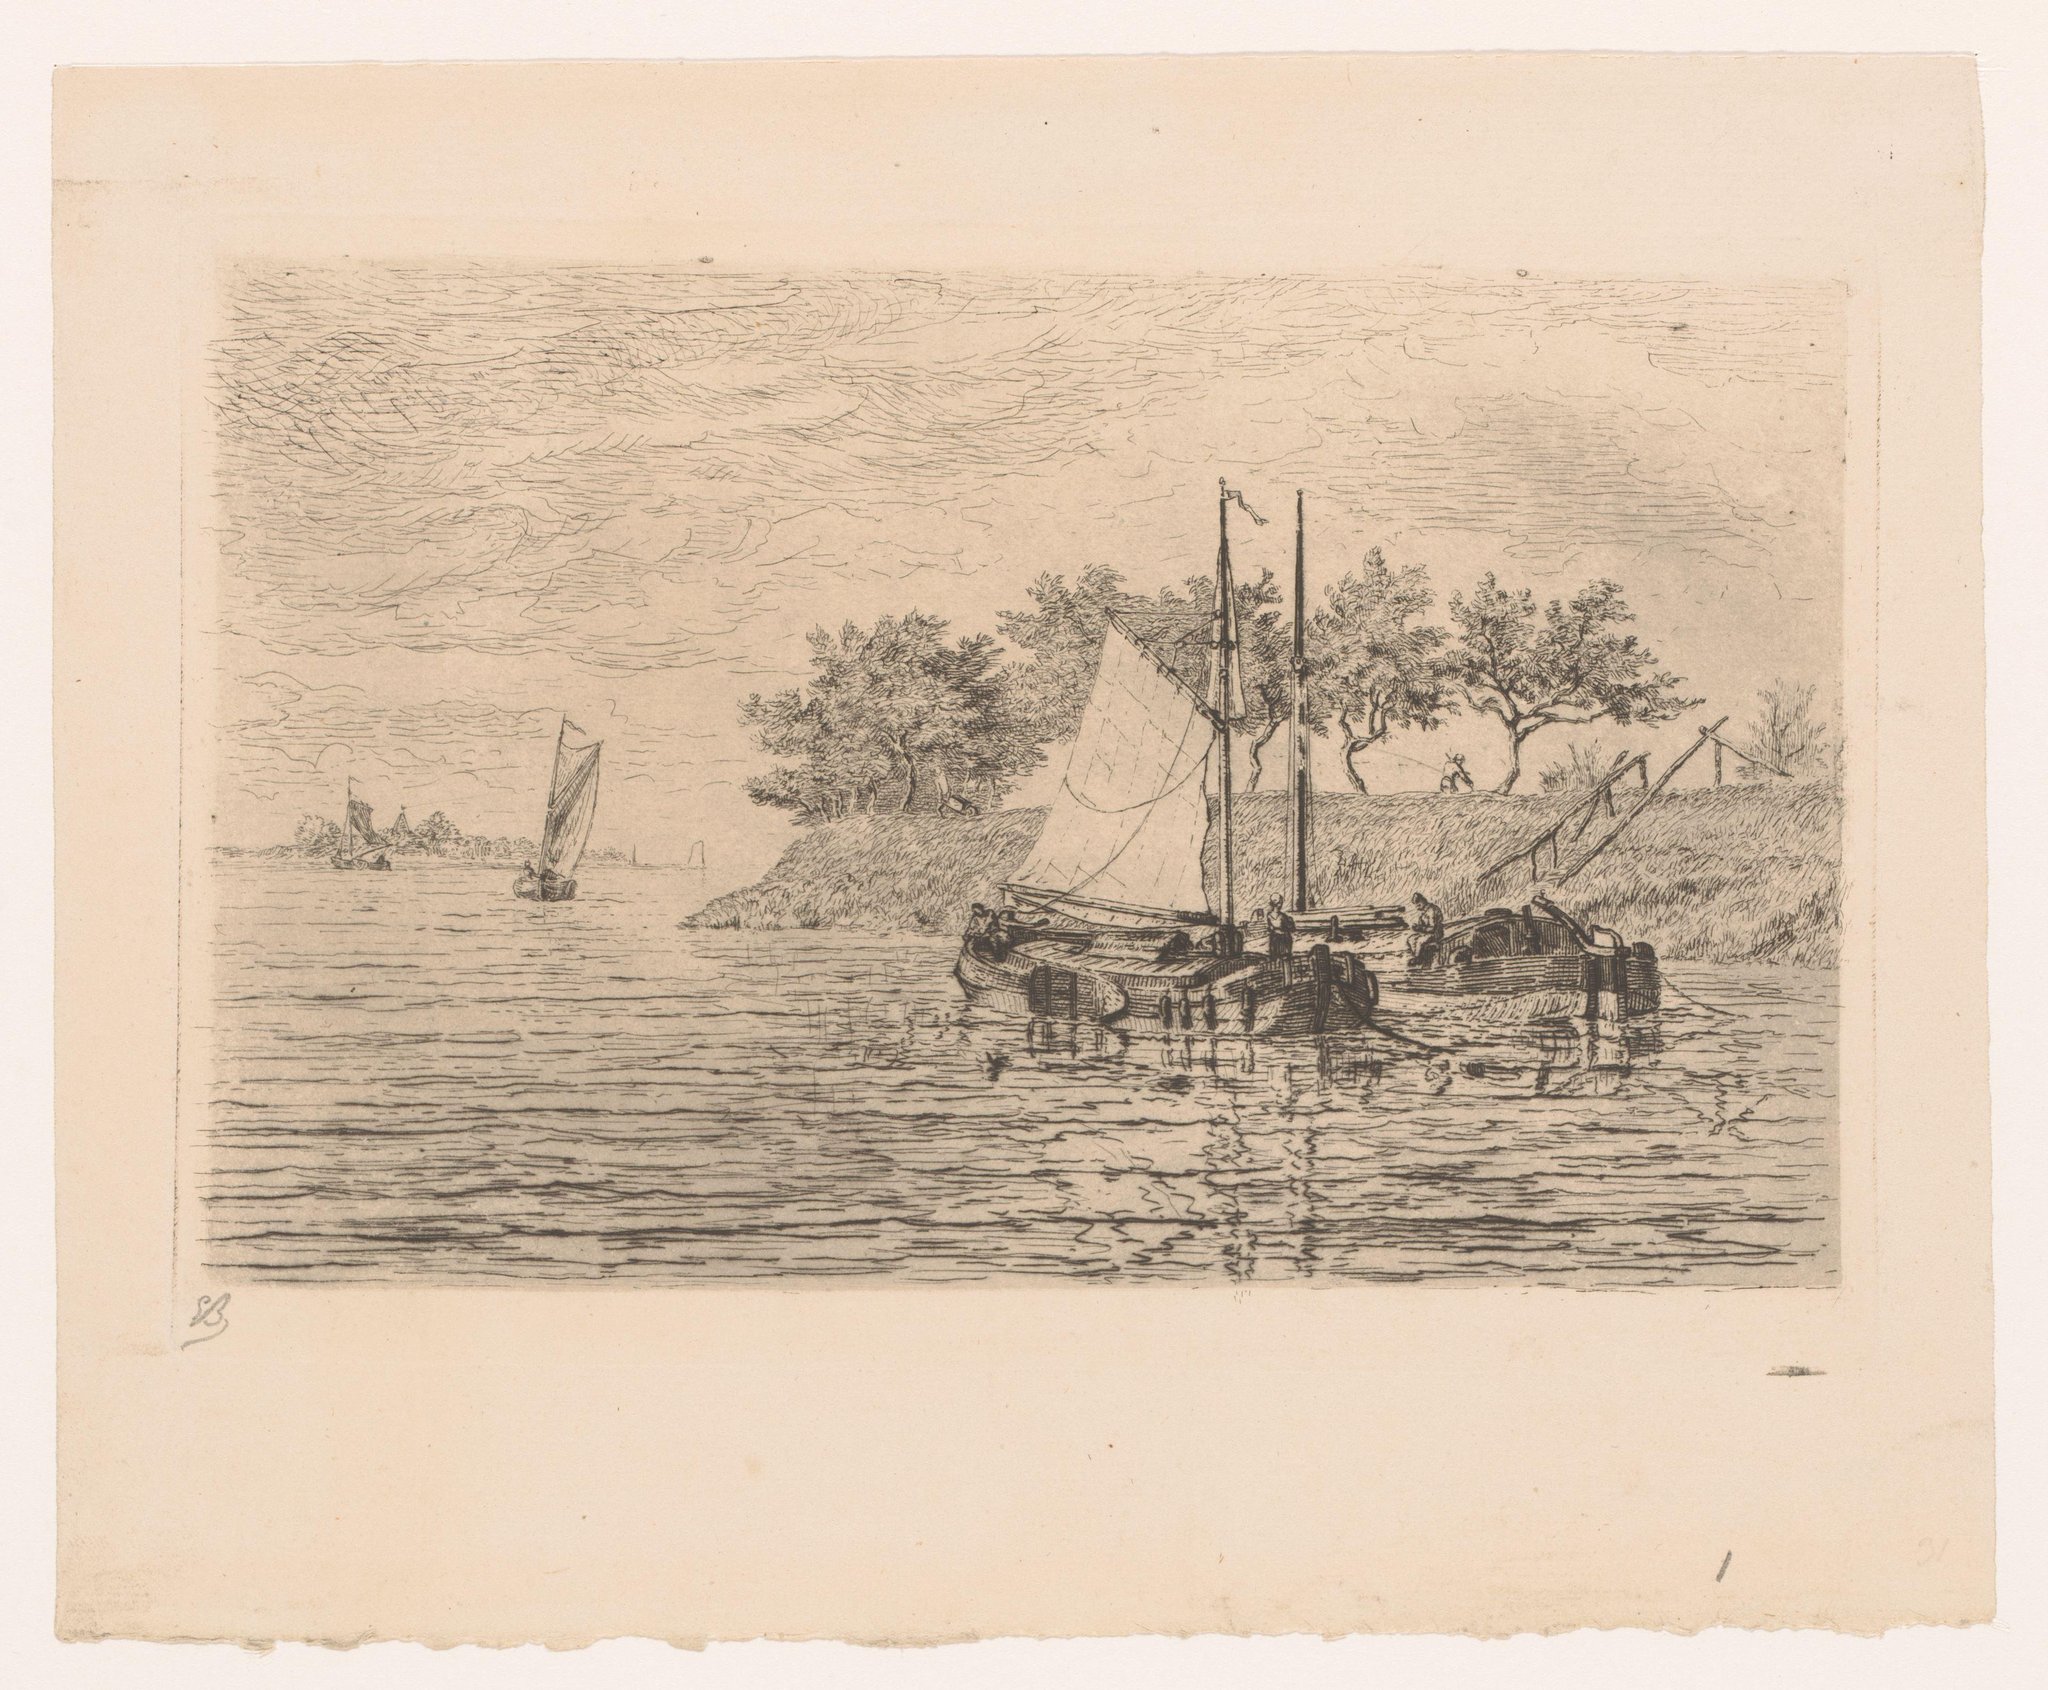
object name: print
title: Zeilboten op een rivier, op de dijk staat een man te maaien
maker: edgar alfred baes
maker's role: print maker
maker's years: 1837-1909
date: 1847-1909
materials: paper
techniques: drypoint, etching, intaglio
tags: sailing-ship, sailing-boat, river, river bank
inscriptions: collector's mark: Lugt 2228, annotation: ‘EB’